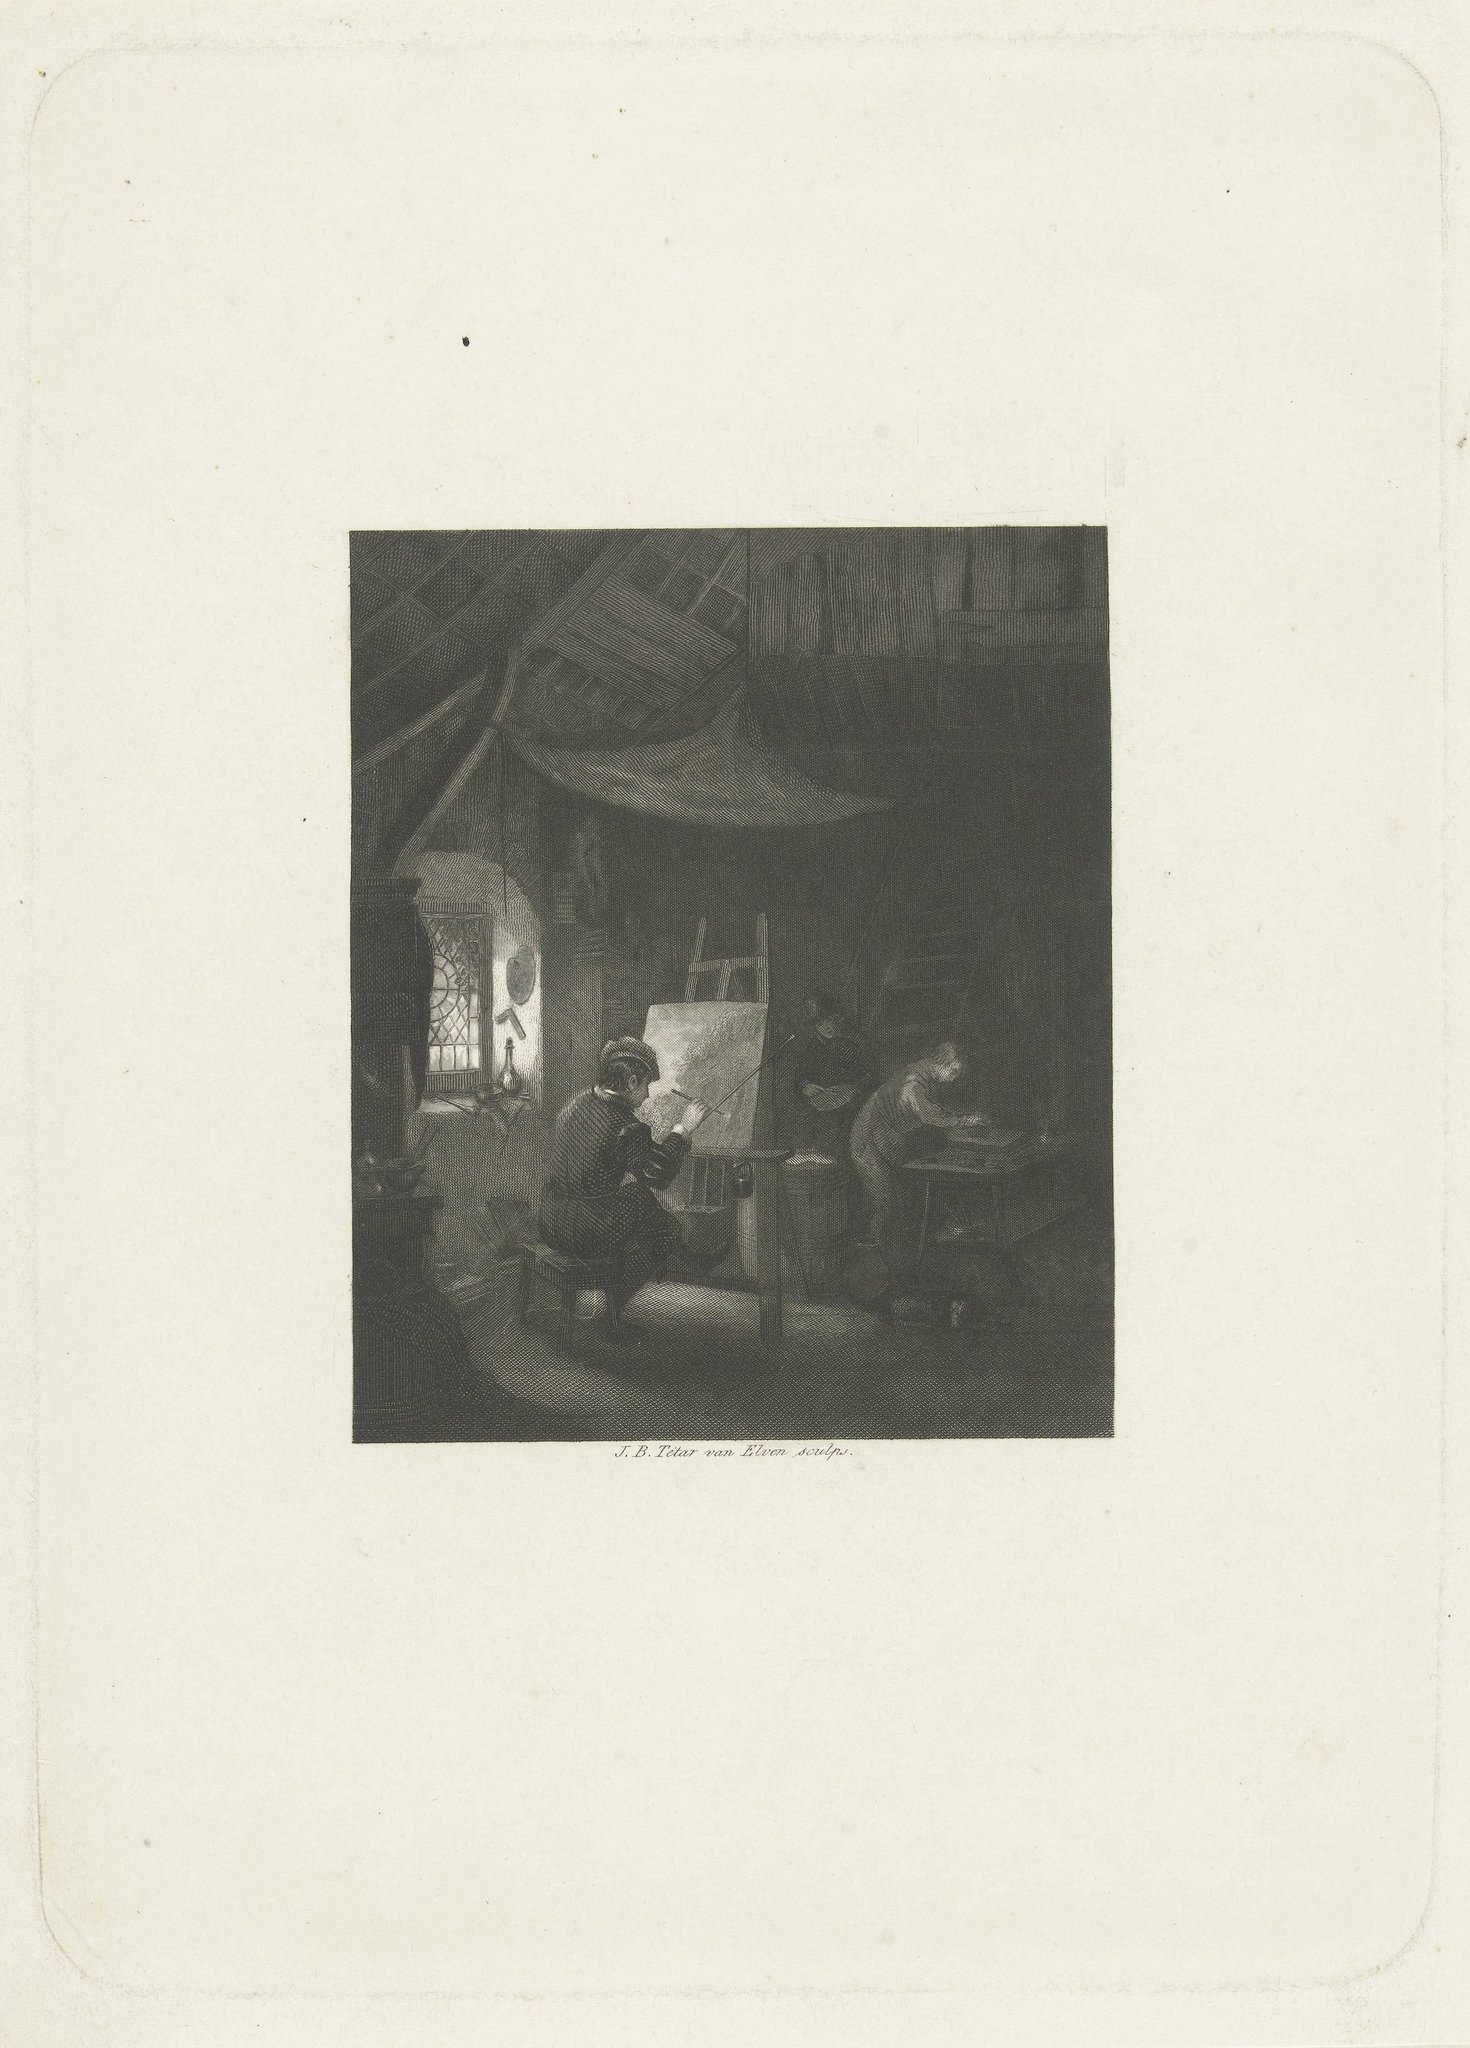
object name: print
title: Schildersatelier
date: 1815-1889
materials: paper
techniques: engraving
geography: netherlands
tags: painter at work, in his studio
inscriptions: collector's mark: Lugt 2228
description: In een atelier, bij het venster zit een schilder voor zijn ezel. Op de achtergrond twee leerlingen en een slapende hond.